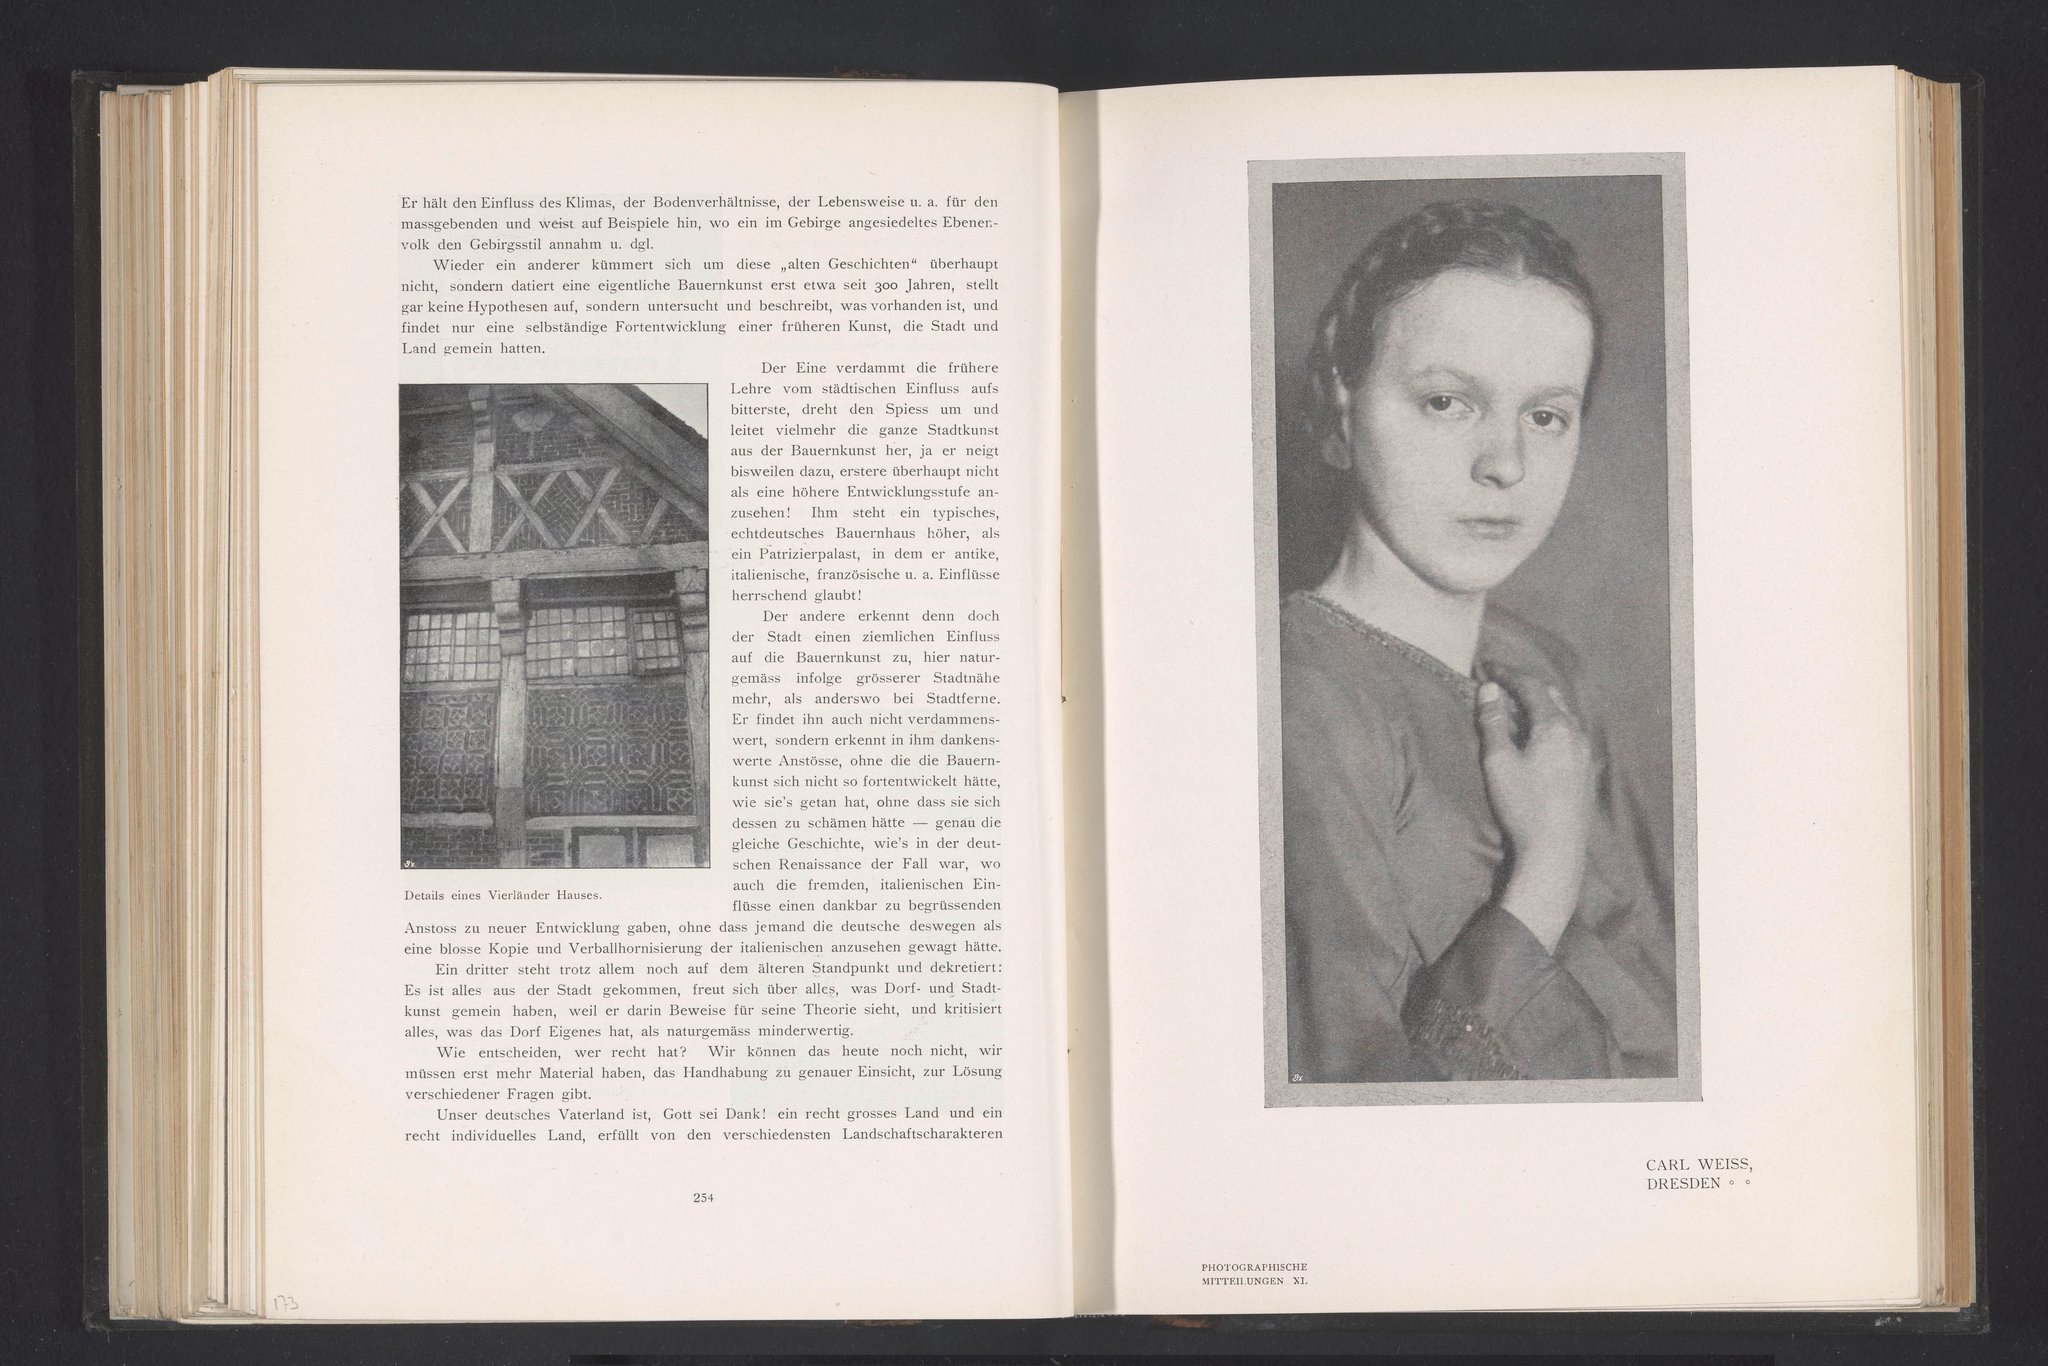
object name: photomechanical print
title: Details eines Vierländer Hauses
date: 1898-1903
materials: paper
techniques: autotype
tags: façade (of house or building), farm or solitary house in landscape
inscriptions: monogram: ‘BX’